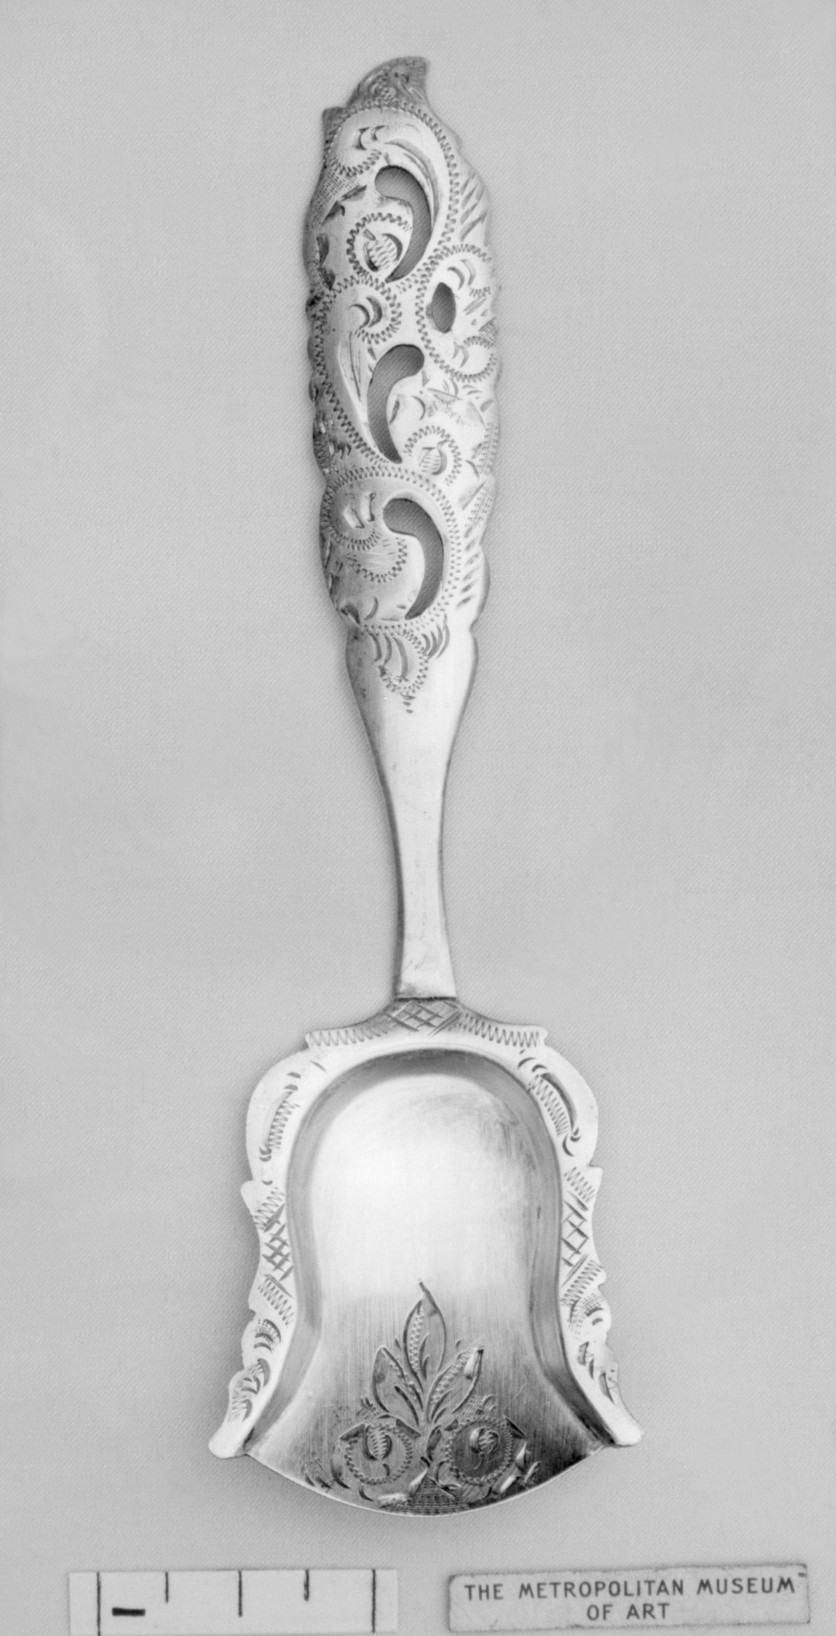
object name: caddy spoon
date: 1867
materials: silver